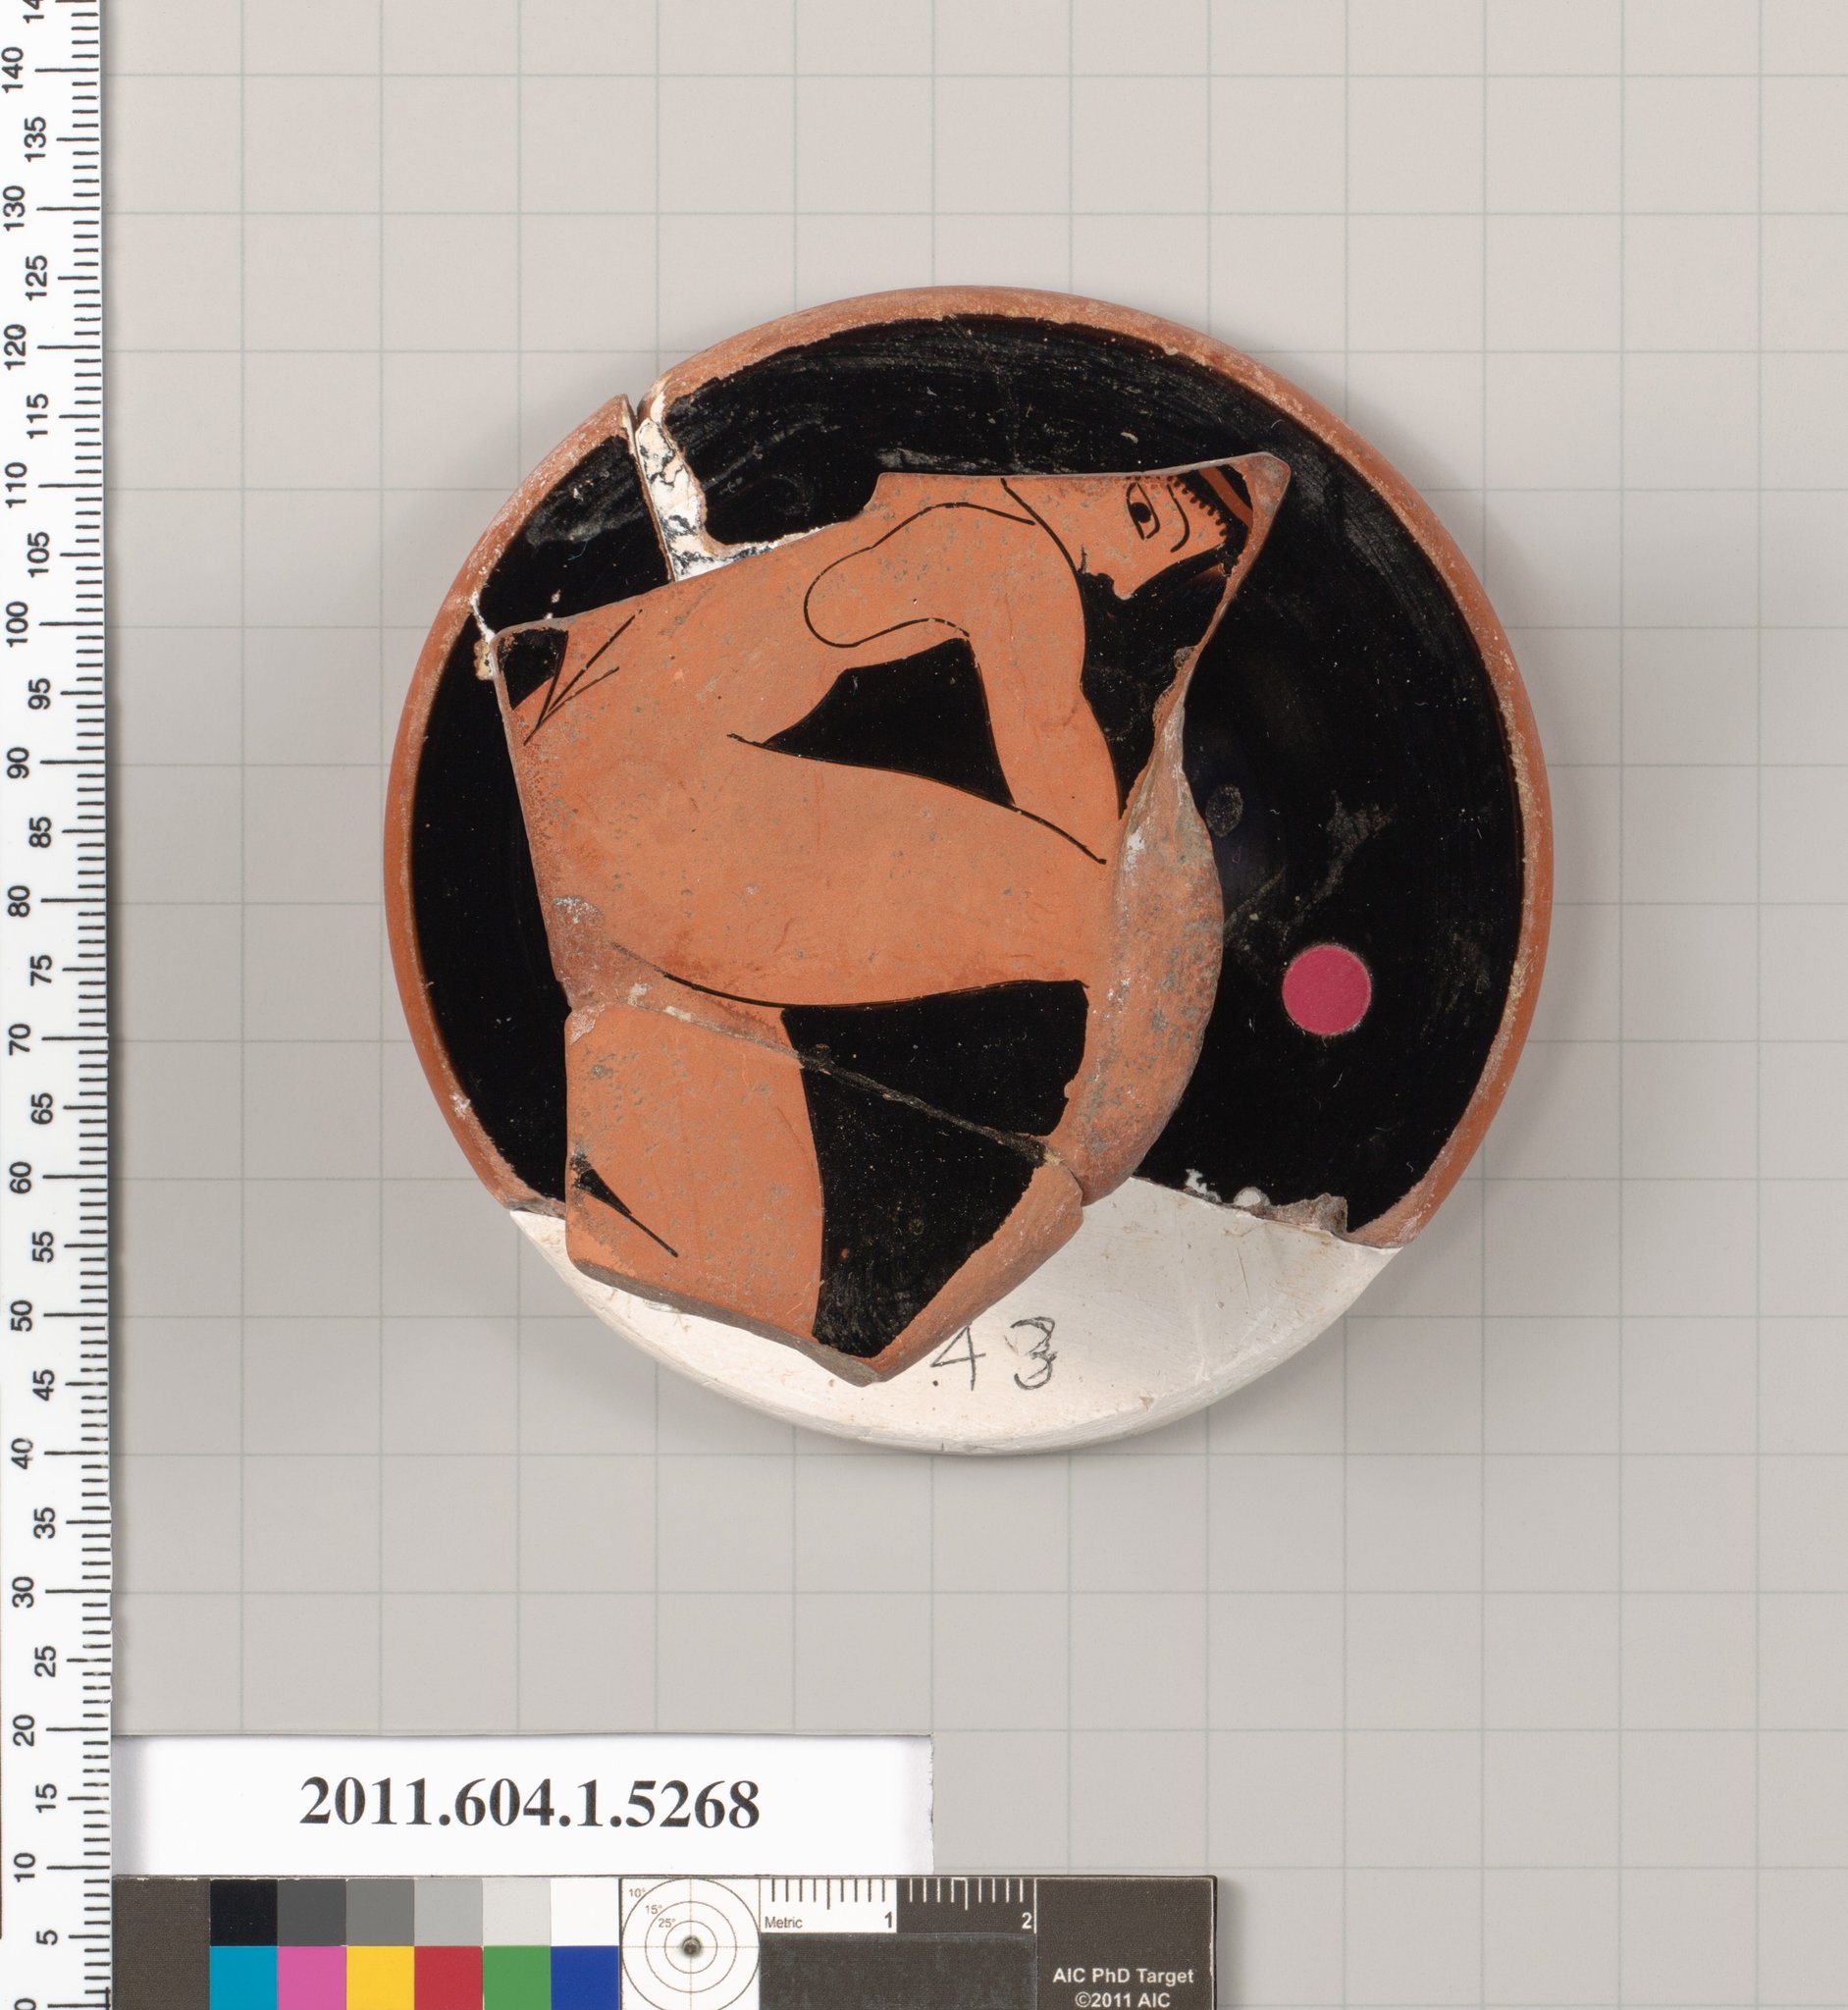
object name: kylix fragment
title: Terracotta fragment of a kylix (drinking cup)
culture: greek, attic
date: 510-500 BCE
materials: terracotta